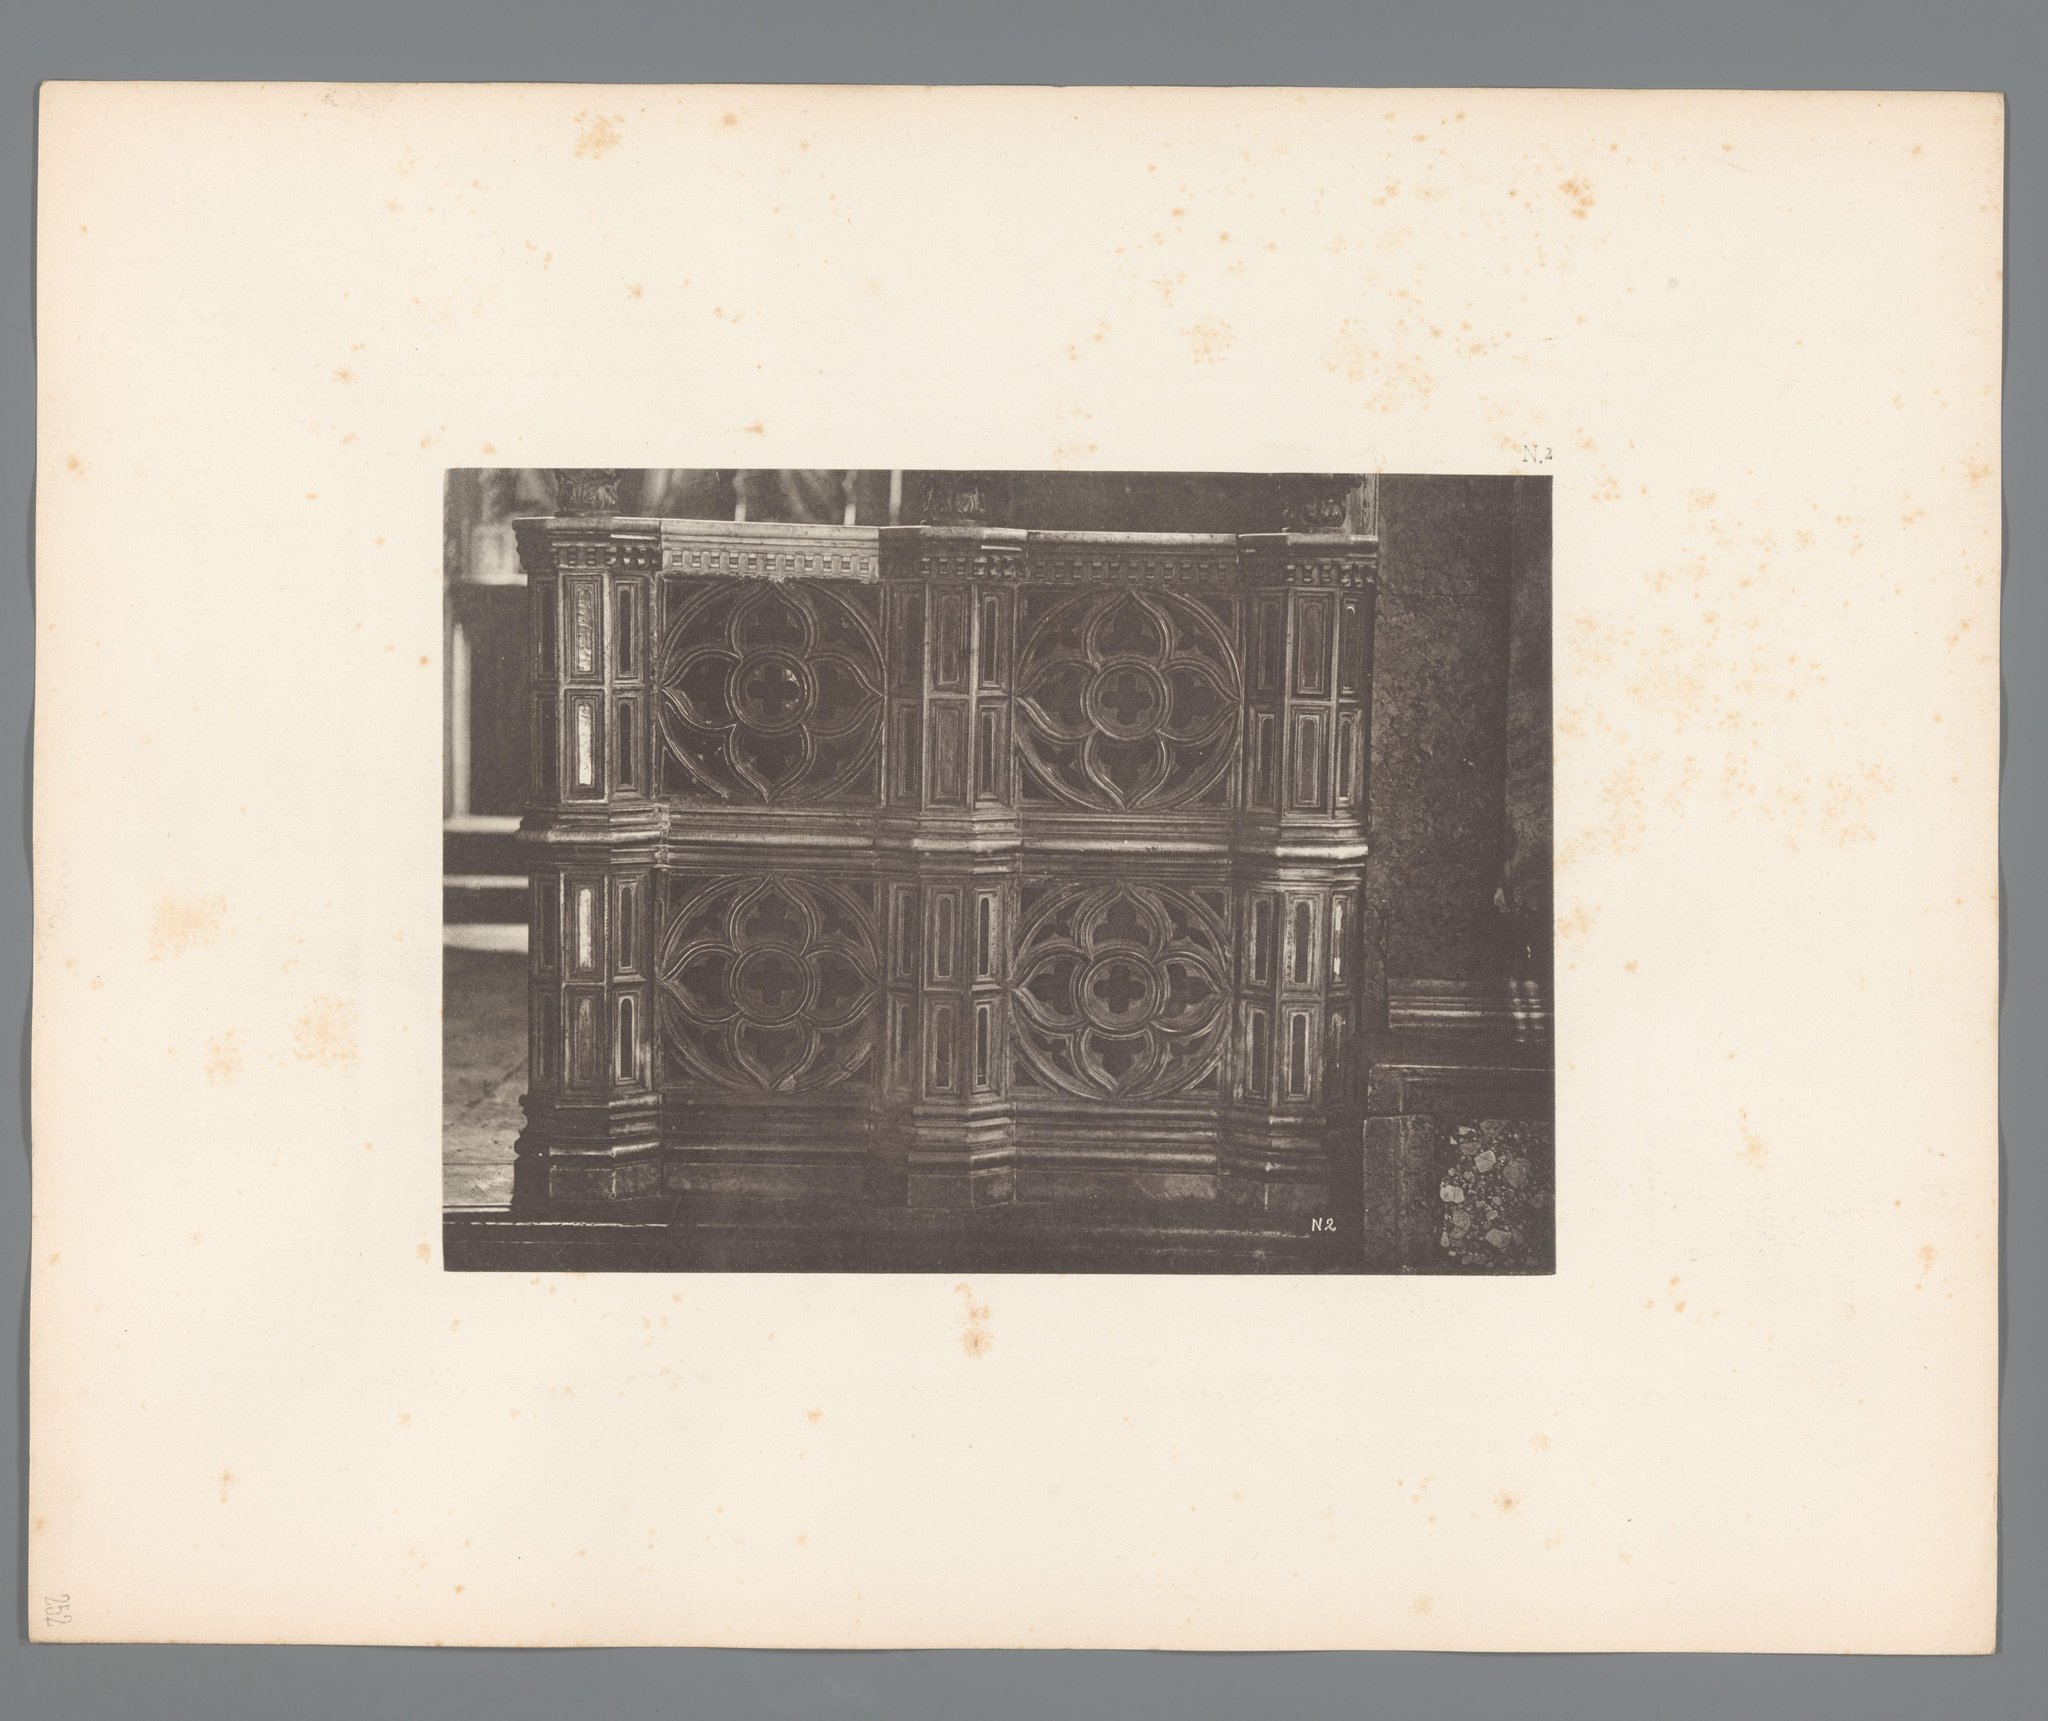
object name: photomechanical print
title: Detail van het interieur van de San Marco in Venetië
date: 1880-1885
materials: paper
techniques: photograph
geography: st. mark's basilica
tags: fence, wall, paling, interior of church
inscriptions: number: ‘N.2’, number: ‘252’, number: ‘N.2’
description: Deze prent maakt deel uit van een omslag met 58 prenten op 50 bladen.